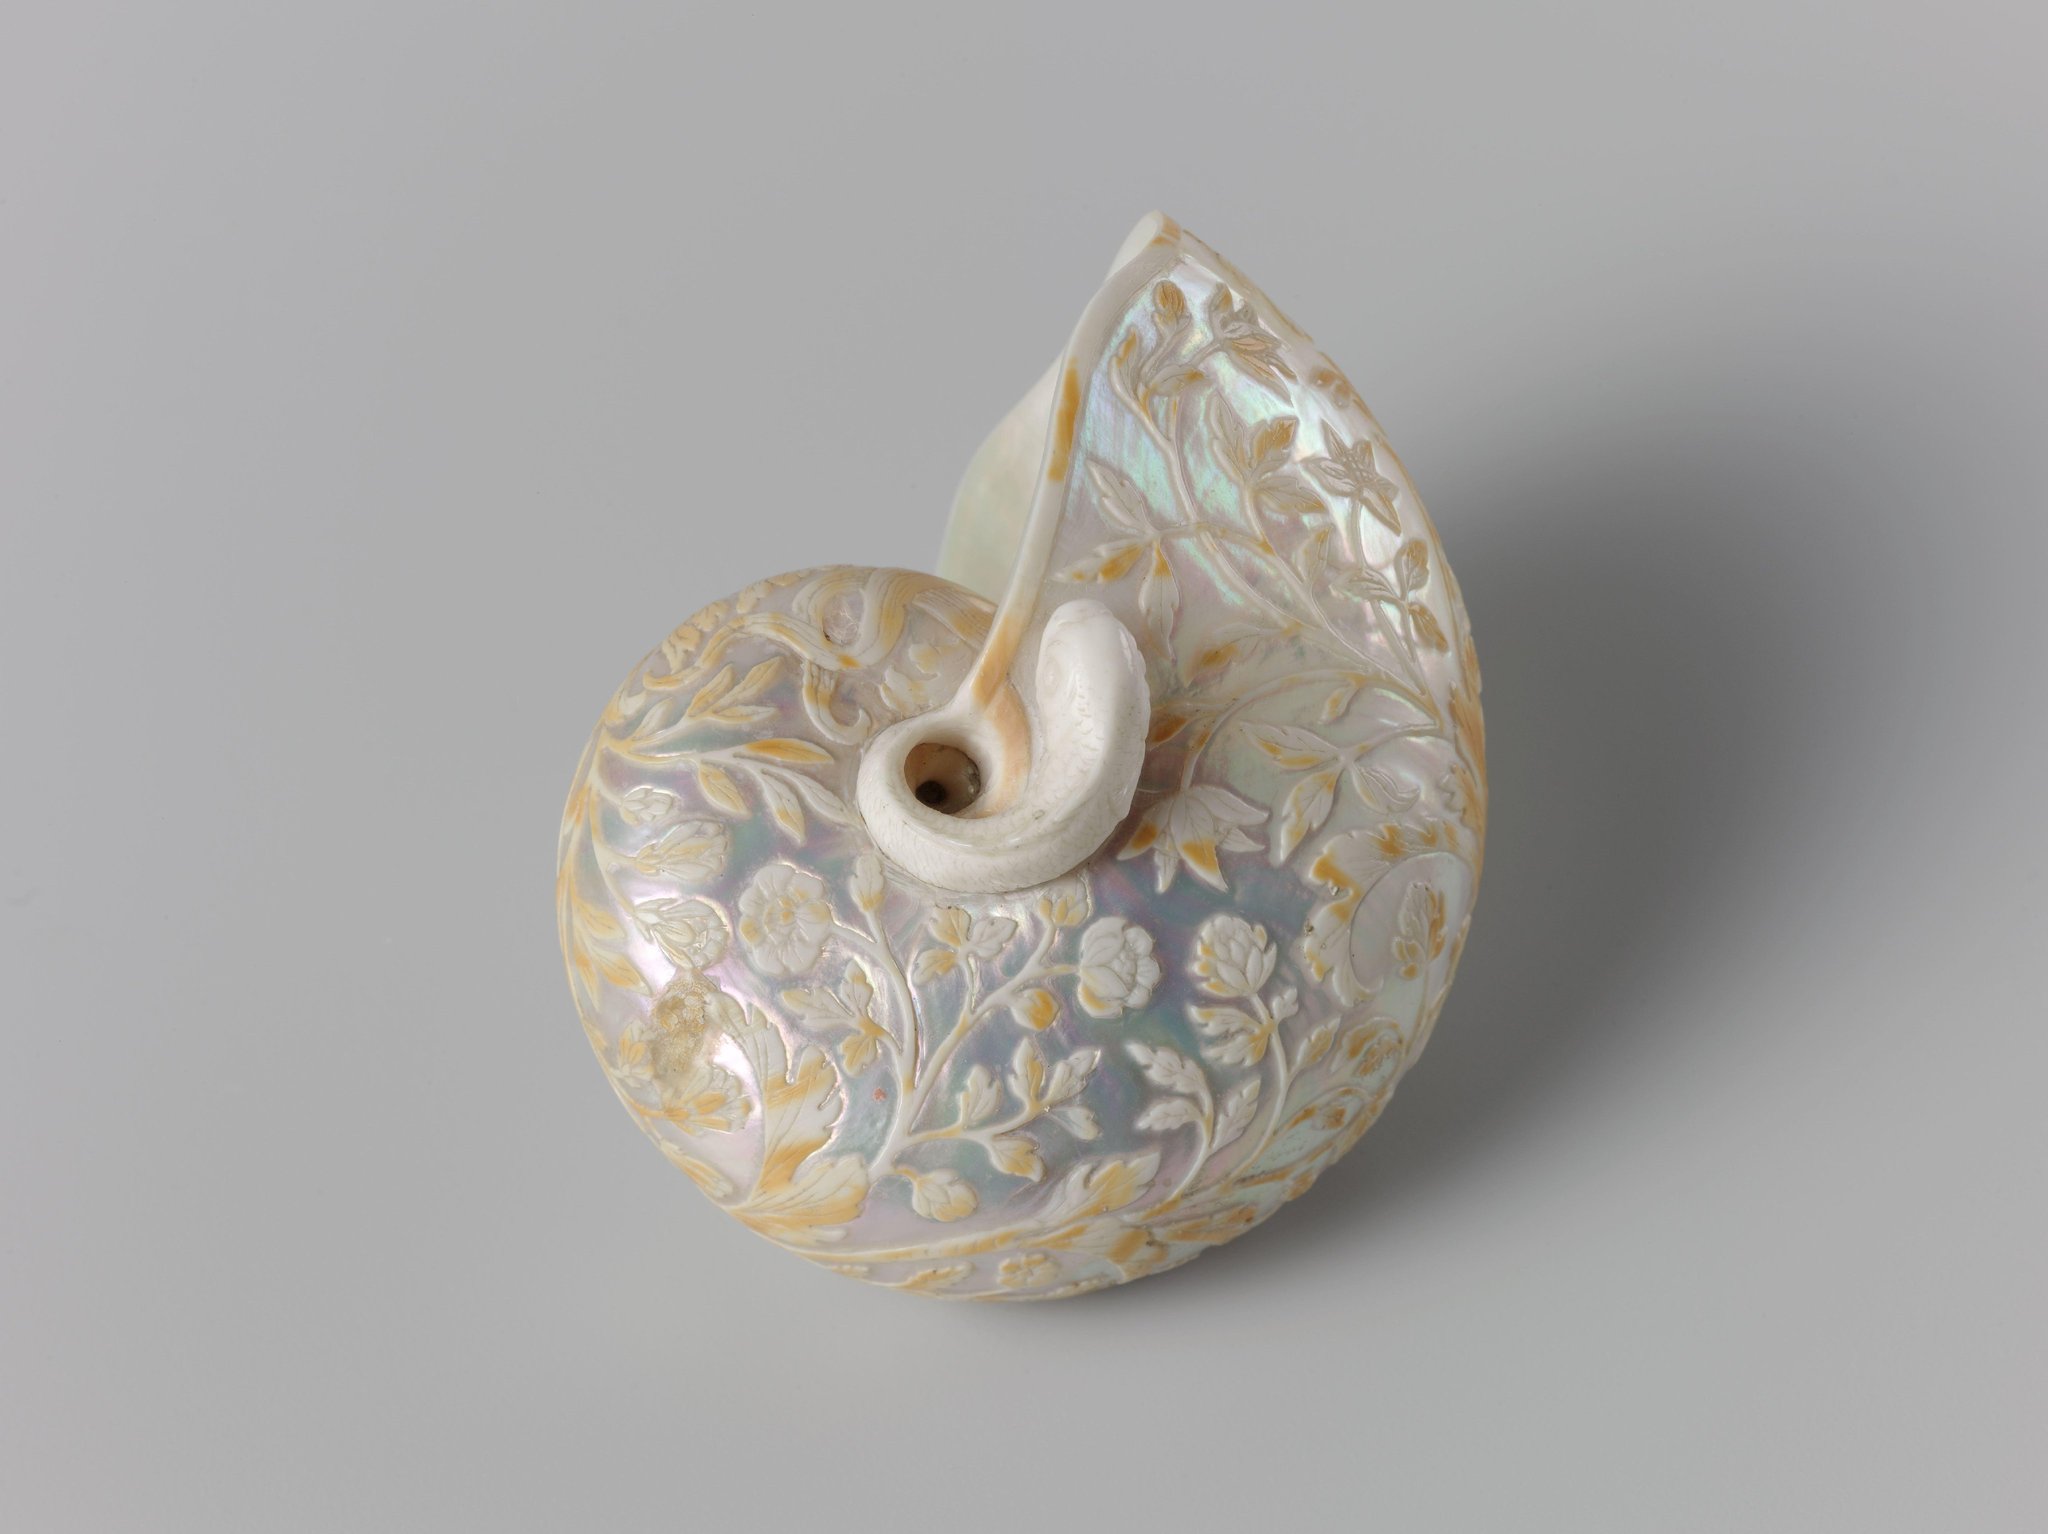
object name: nautilus shell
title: Nautilusschelp van parelmoer gesneden met bloemenranken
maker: cornelis bellekin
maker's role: jeweler, painter, print maker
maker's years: 1625-1711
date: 1650-1700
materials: mother of pearl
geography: amsterdam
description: Nautilusschelp versierd met uit de mantel gesneden bloemenranken en uit de dikte om de navel uitgespaarde dolfijnen. Nautilusschelp losgemaakt van de (afzonderlijk bewaarde) niet originele voet. Noordelijke Nederlanden, tweede helft 17de eeuw. Gesigneerd Cbf.